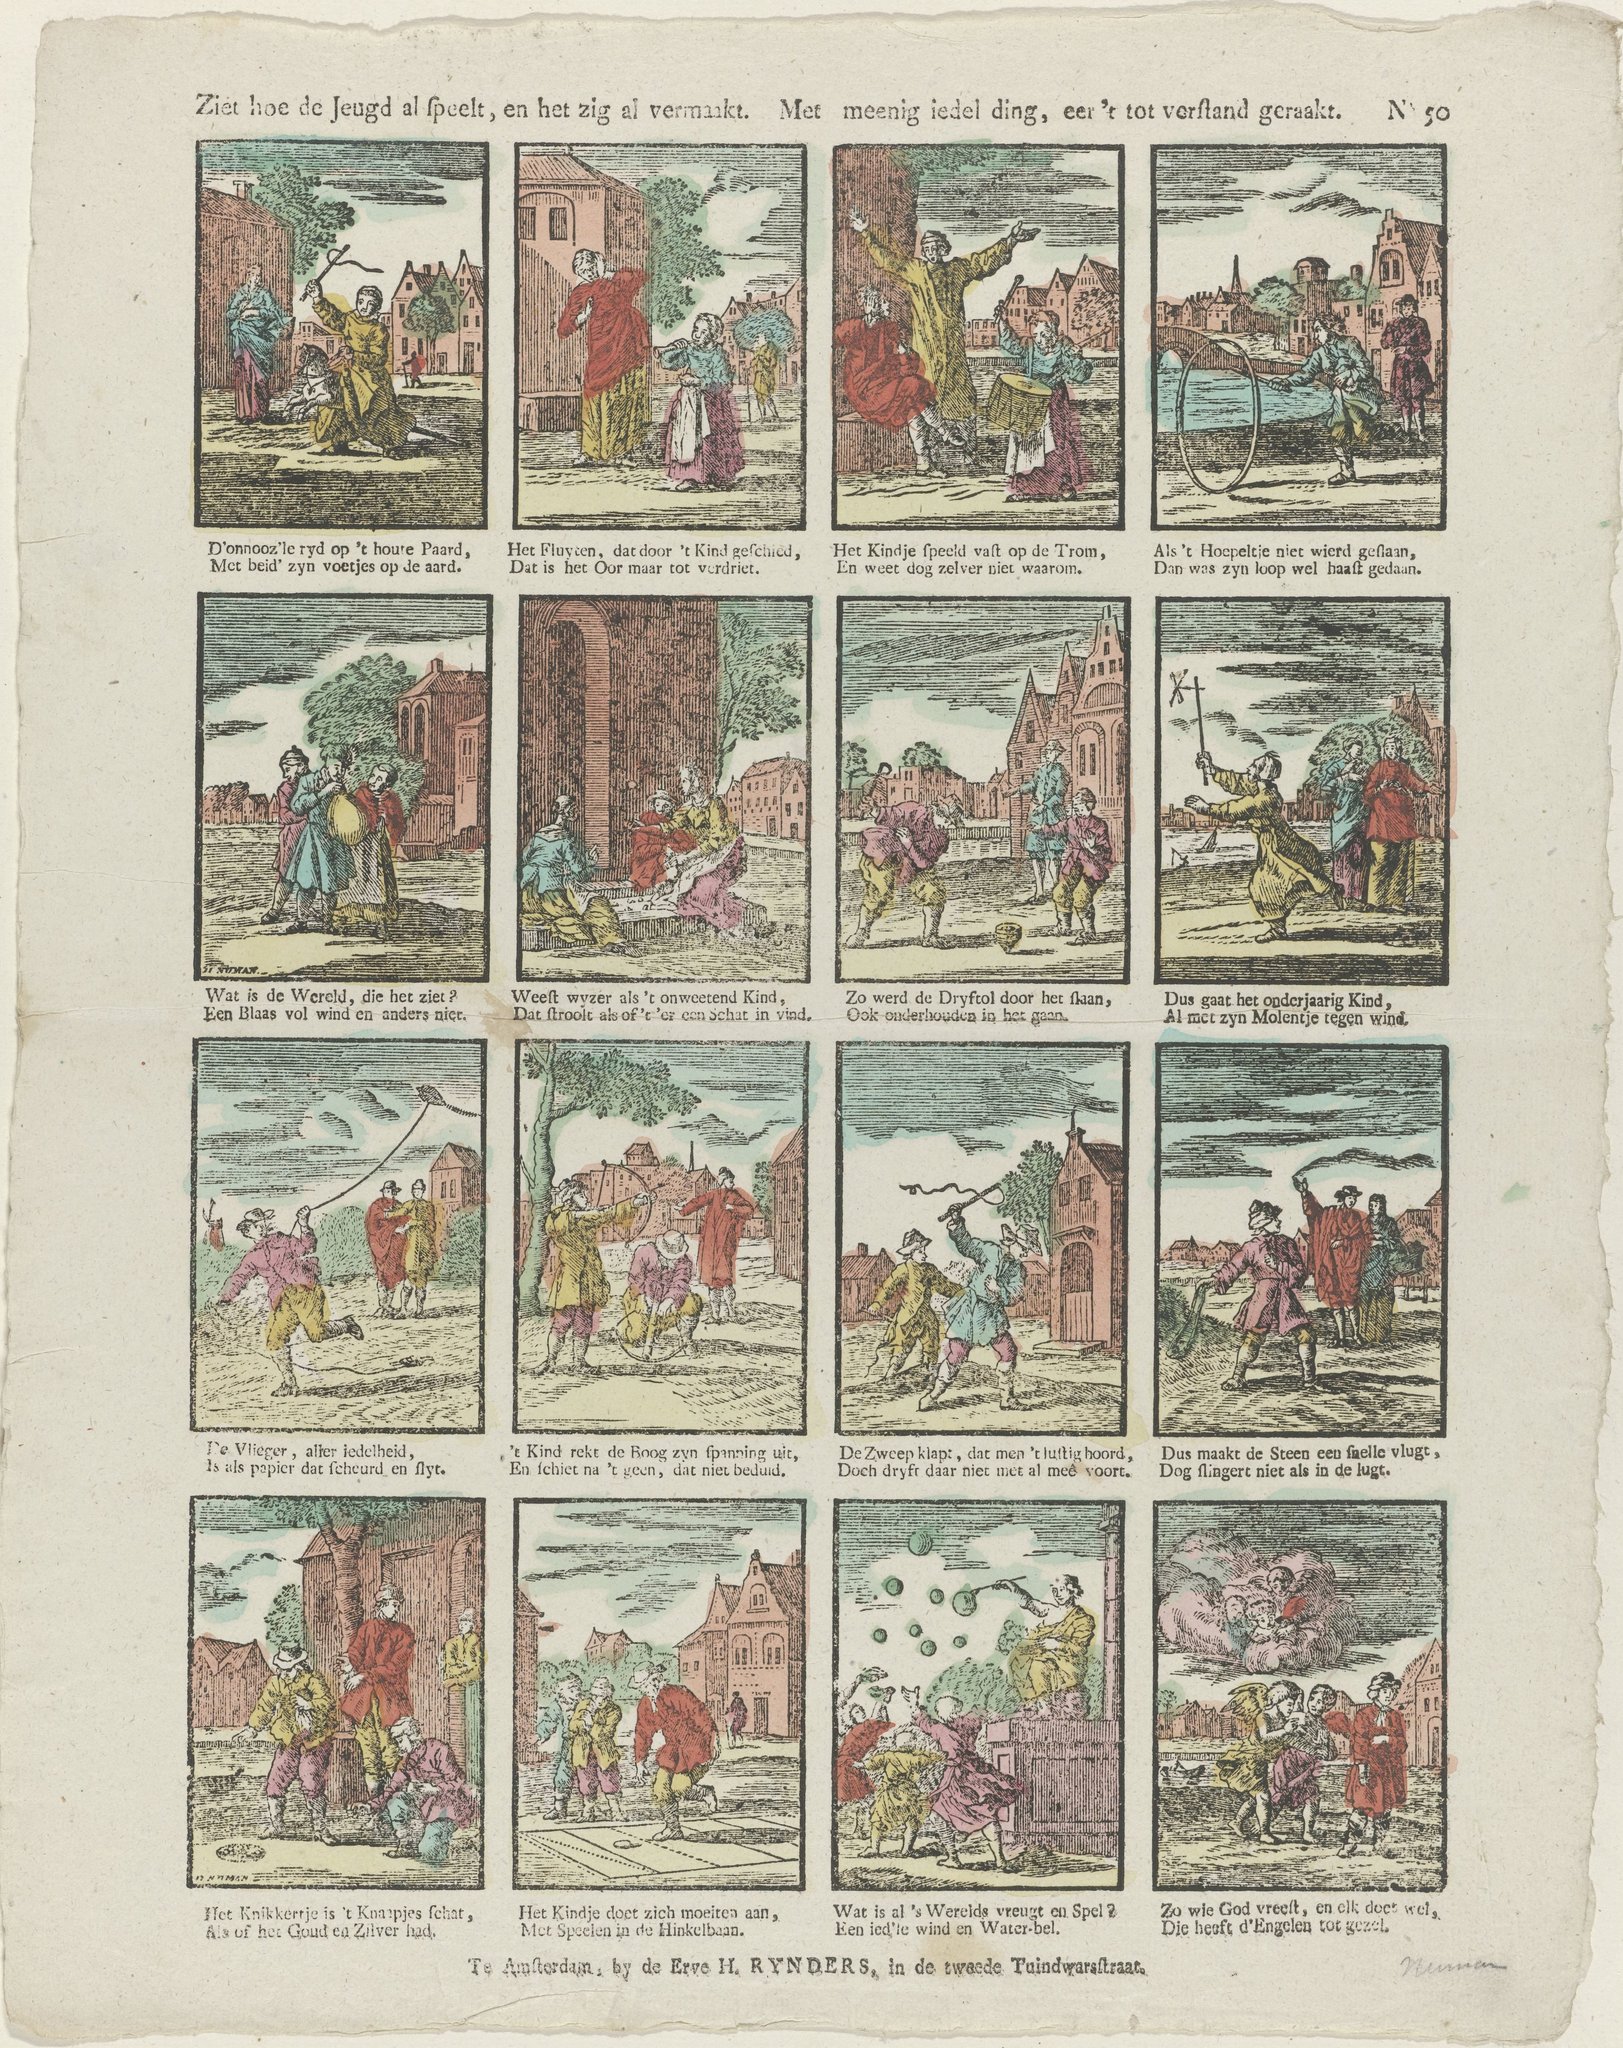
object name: print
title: Ziet hoe de jeugd al speelt, en het zig al vermaakt. / Met meenig iedel ding, eer 't tot verstand geraakt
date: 1781-1854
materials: paper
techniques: colour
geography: amsterdam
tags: bubble-blowing (children's games and plays), children's games and plays, (flying a) kite, games using special objects (marbles, top, hoop, etc.)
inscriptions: collector's mark: Lugt 2228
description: Blad met 16 voorstellingen van kinderspelen, zoals stokpaardje rijden, hoepelen en vliegeren. Onder elke afbeelding een tweeregelig vers. Genummerd rechtsboven: N 50.